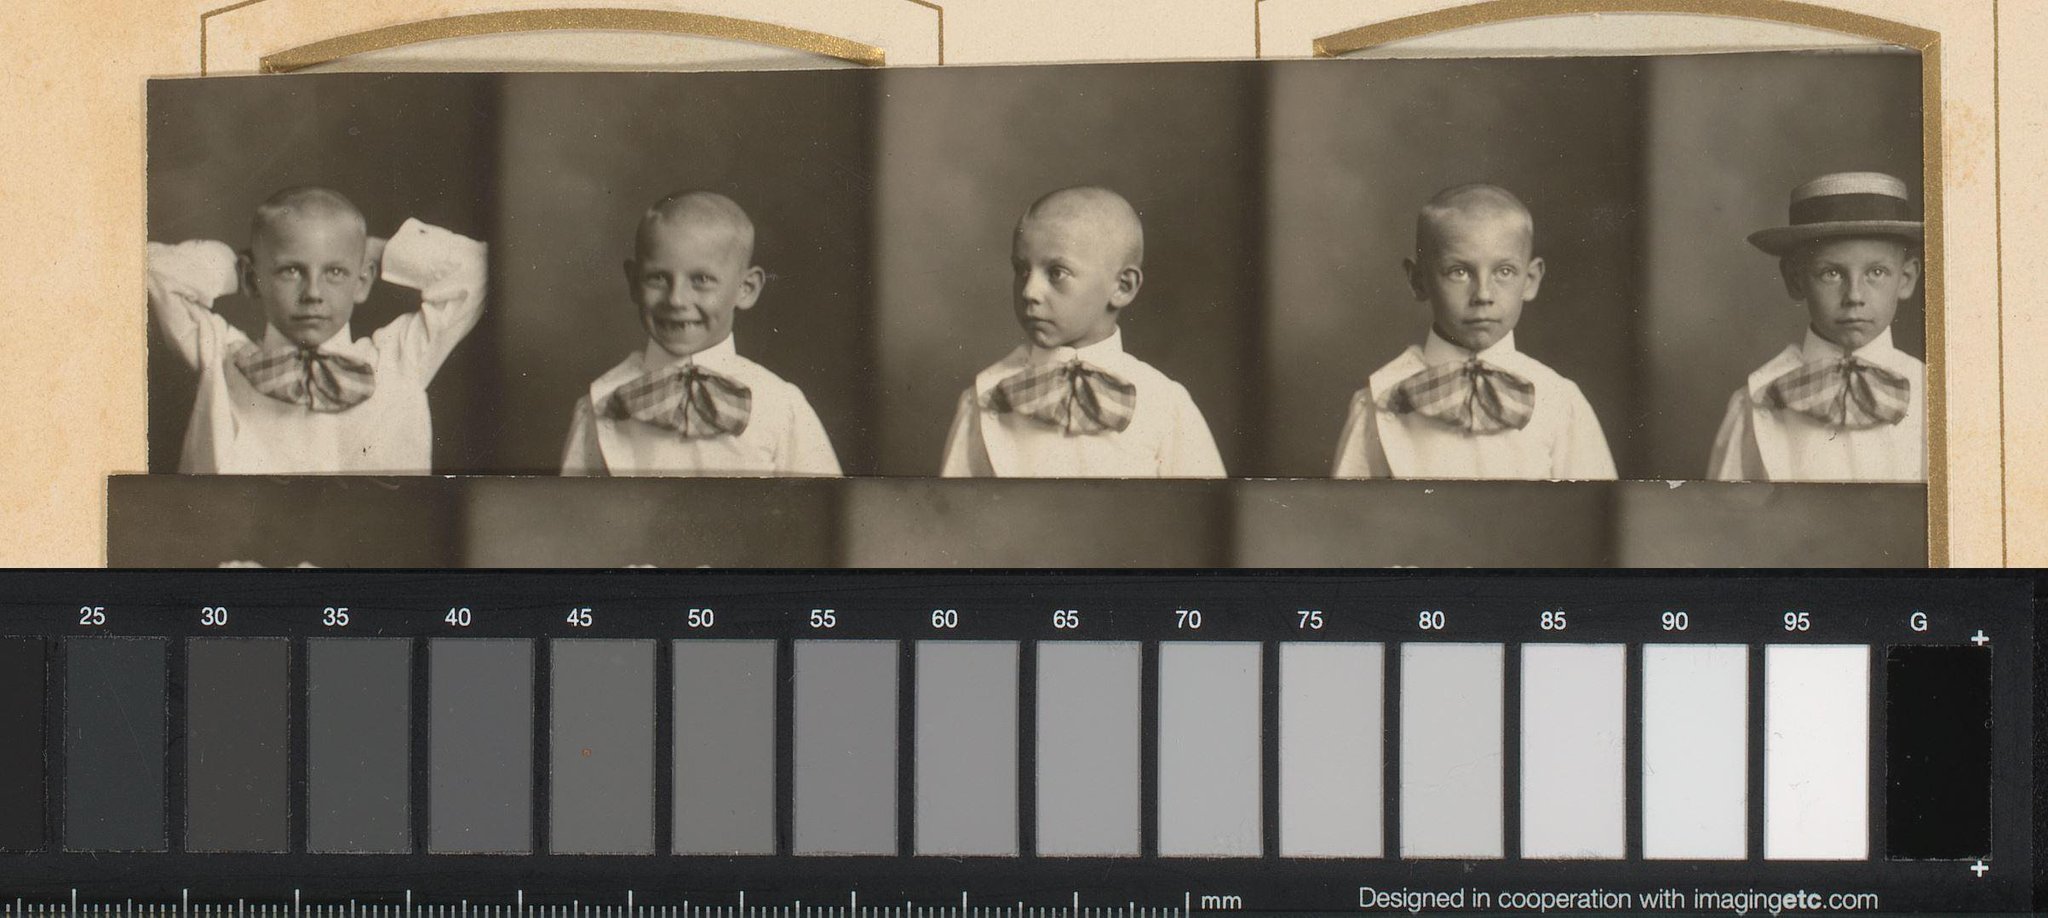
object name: album leaf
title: Vijf portretten van een jongen, waarvan één met hoed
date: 1915-1930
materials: photographic support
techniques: gelatin silver print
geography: saint louis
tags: boy (child between toddler and youth), historical persons, head-gear: hat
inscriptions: inscription: ‘Laurello Studio,/ 618-620 Olive St.,/ St. Louis, Mo.’